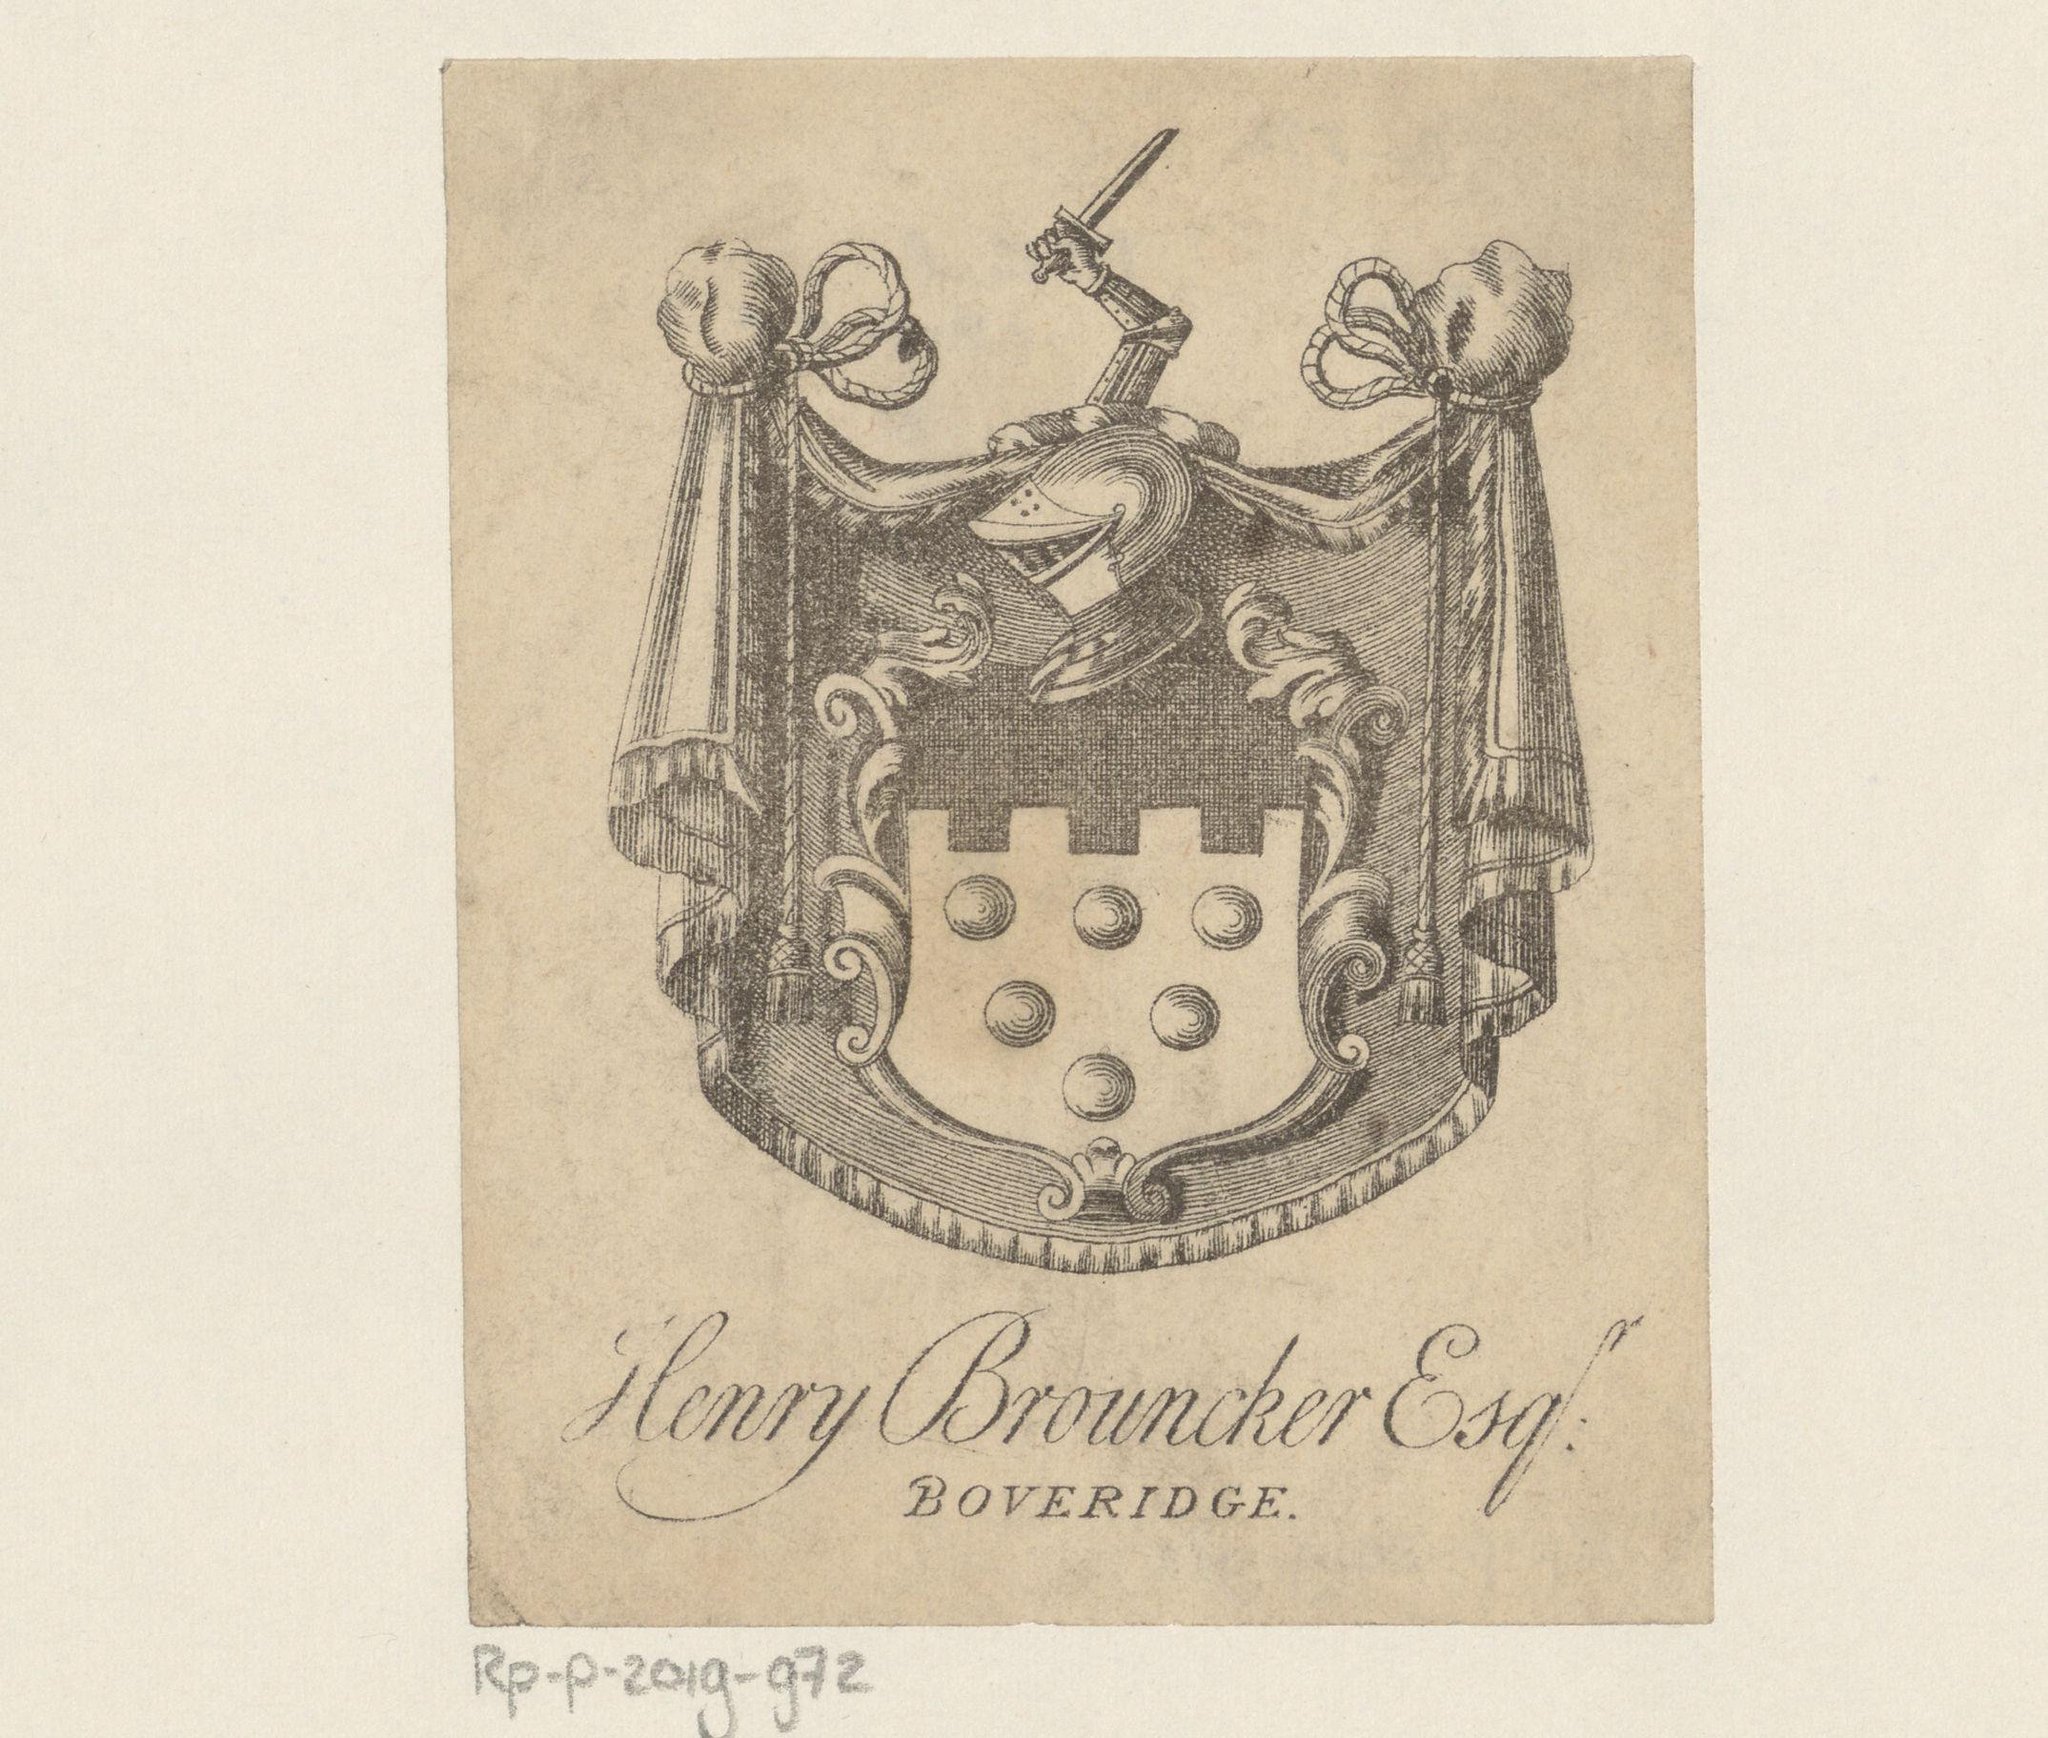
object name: bookplate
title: Ex libris van Henry Brouncker Esqr.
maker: Anonymous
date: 1750-1849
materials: paper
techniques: engraving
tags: armorial bearing, heraldry